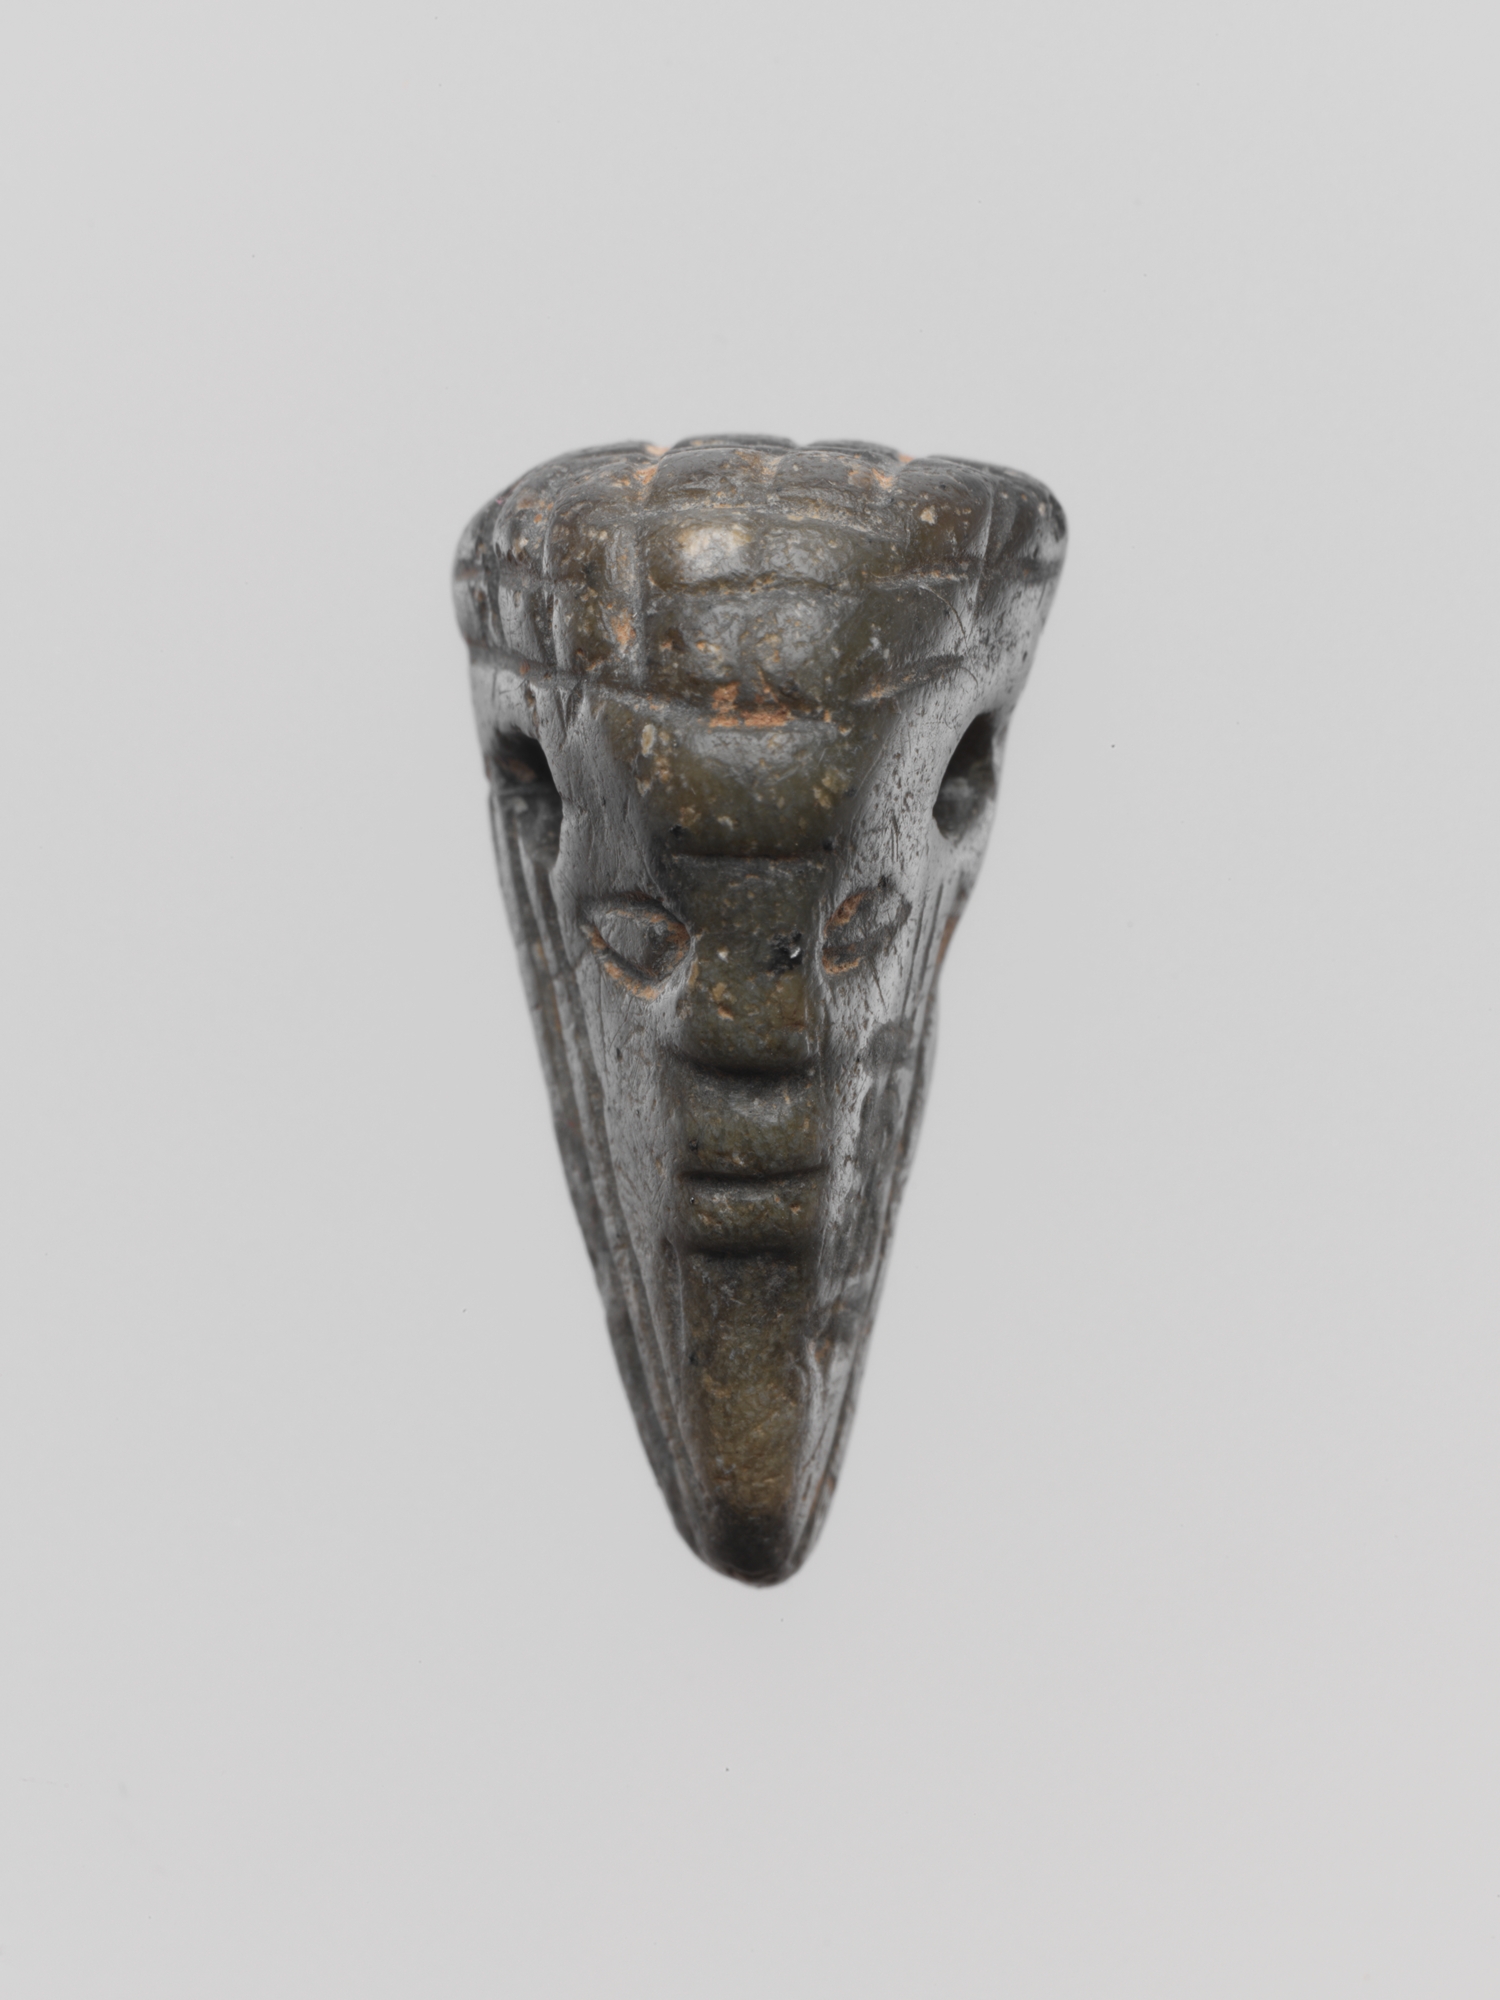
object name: pendant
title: Chlorite pendant in the form of the head of an Assyrian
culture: cypriot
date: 600-501 BCE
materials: stone